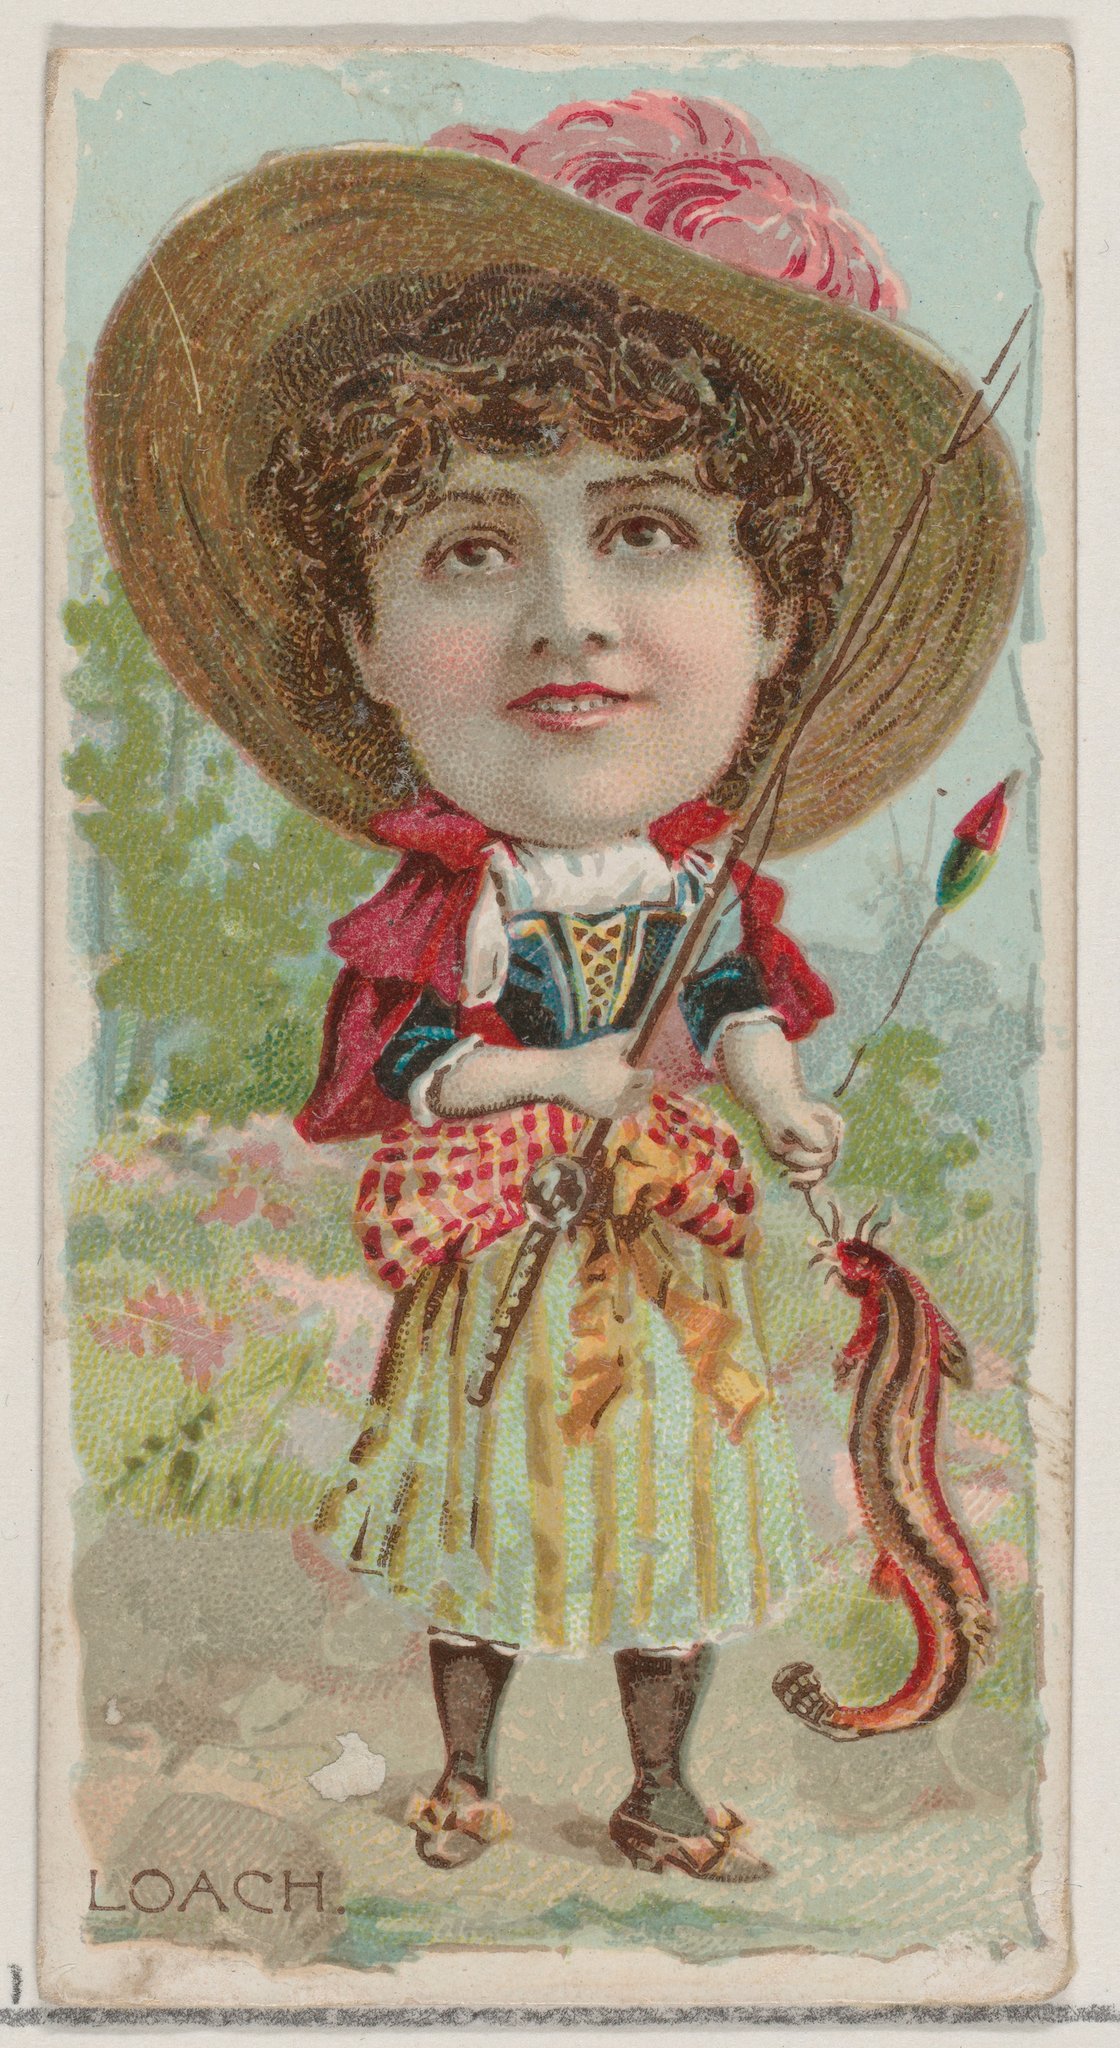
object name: print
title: Loach, from the series Fishers and Fish (N74) for Duke brand cigarettes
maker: knapp & company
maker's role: lithographer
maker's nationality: american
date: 1888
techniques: color lithograph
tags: women,fishing,fish